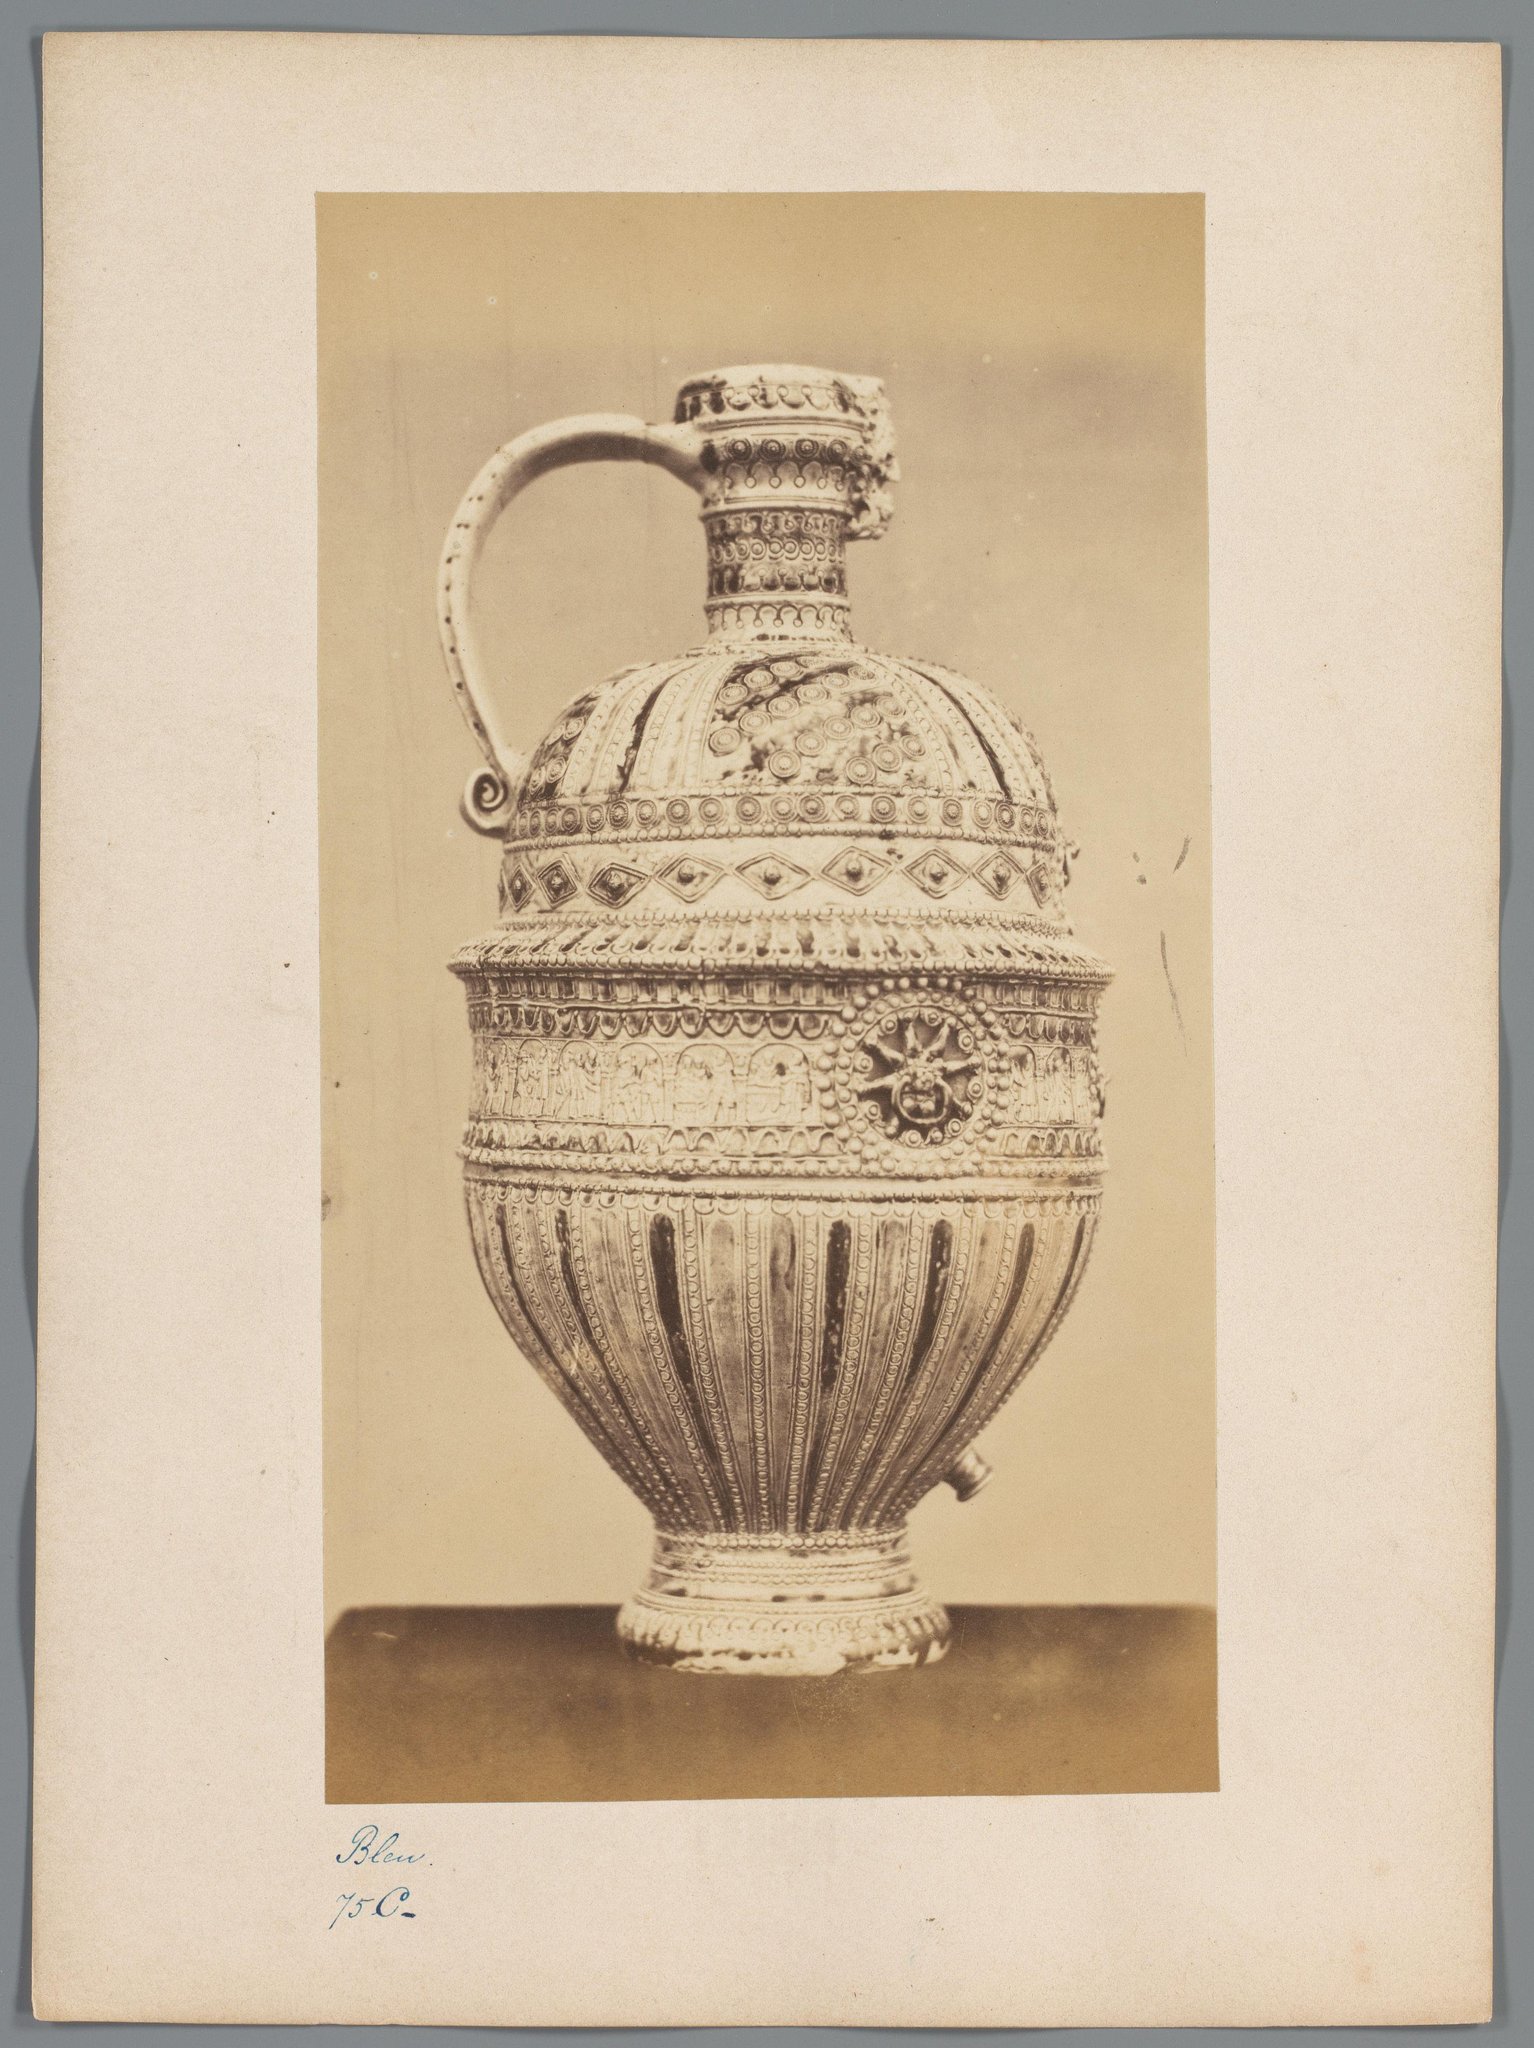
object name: photograph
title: Aardewerken vaas uit de collectie van W. de Weckherlin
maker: Anonymous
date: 1860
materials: paper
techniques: albumen print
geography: the hague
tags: container of ceramics: jar, jug, pot, vase, the hague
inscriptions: inscription: ‘Blue./ 75C.’